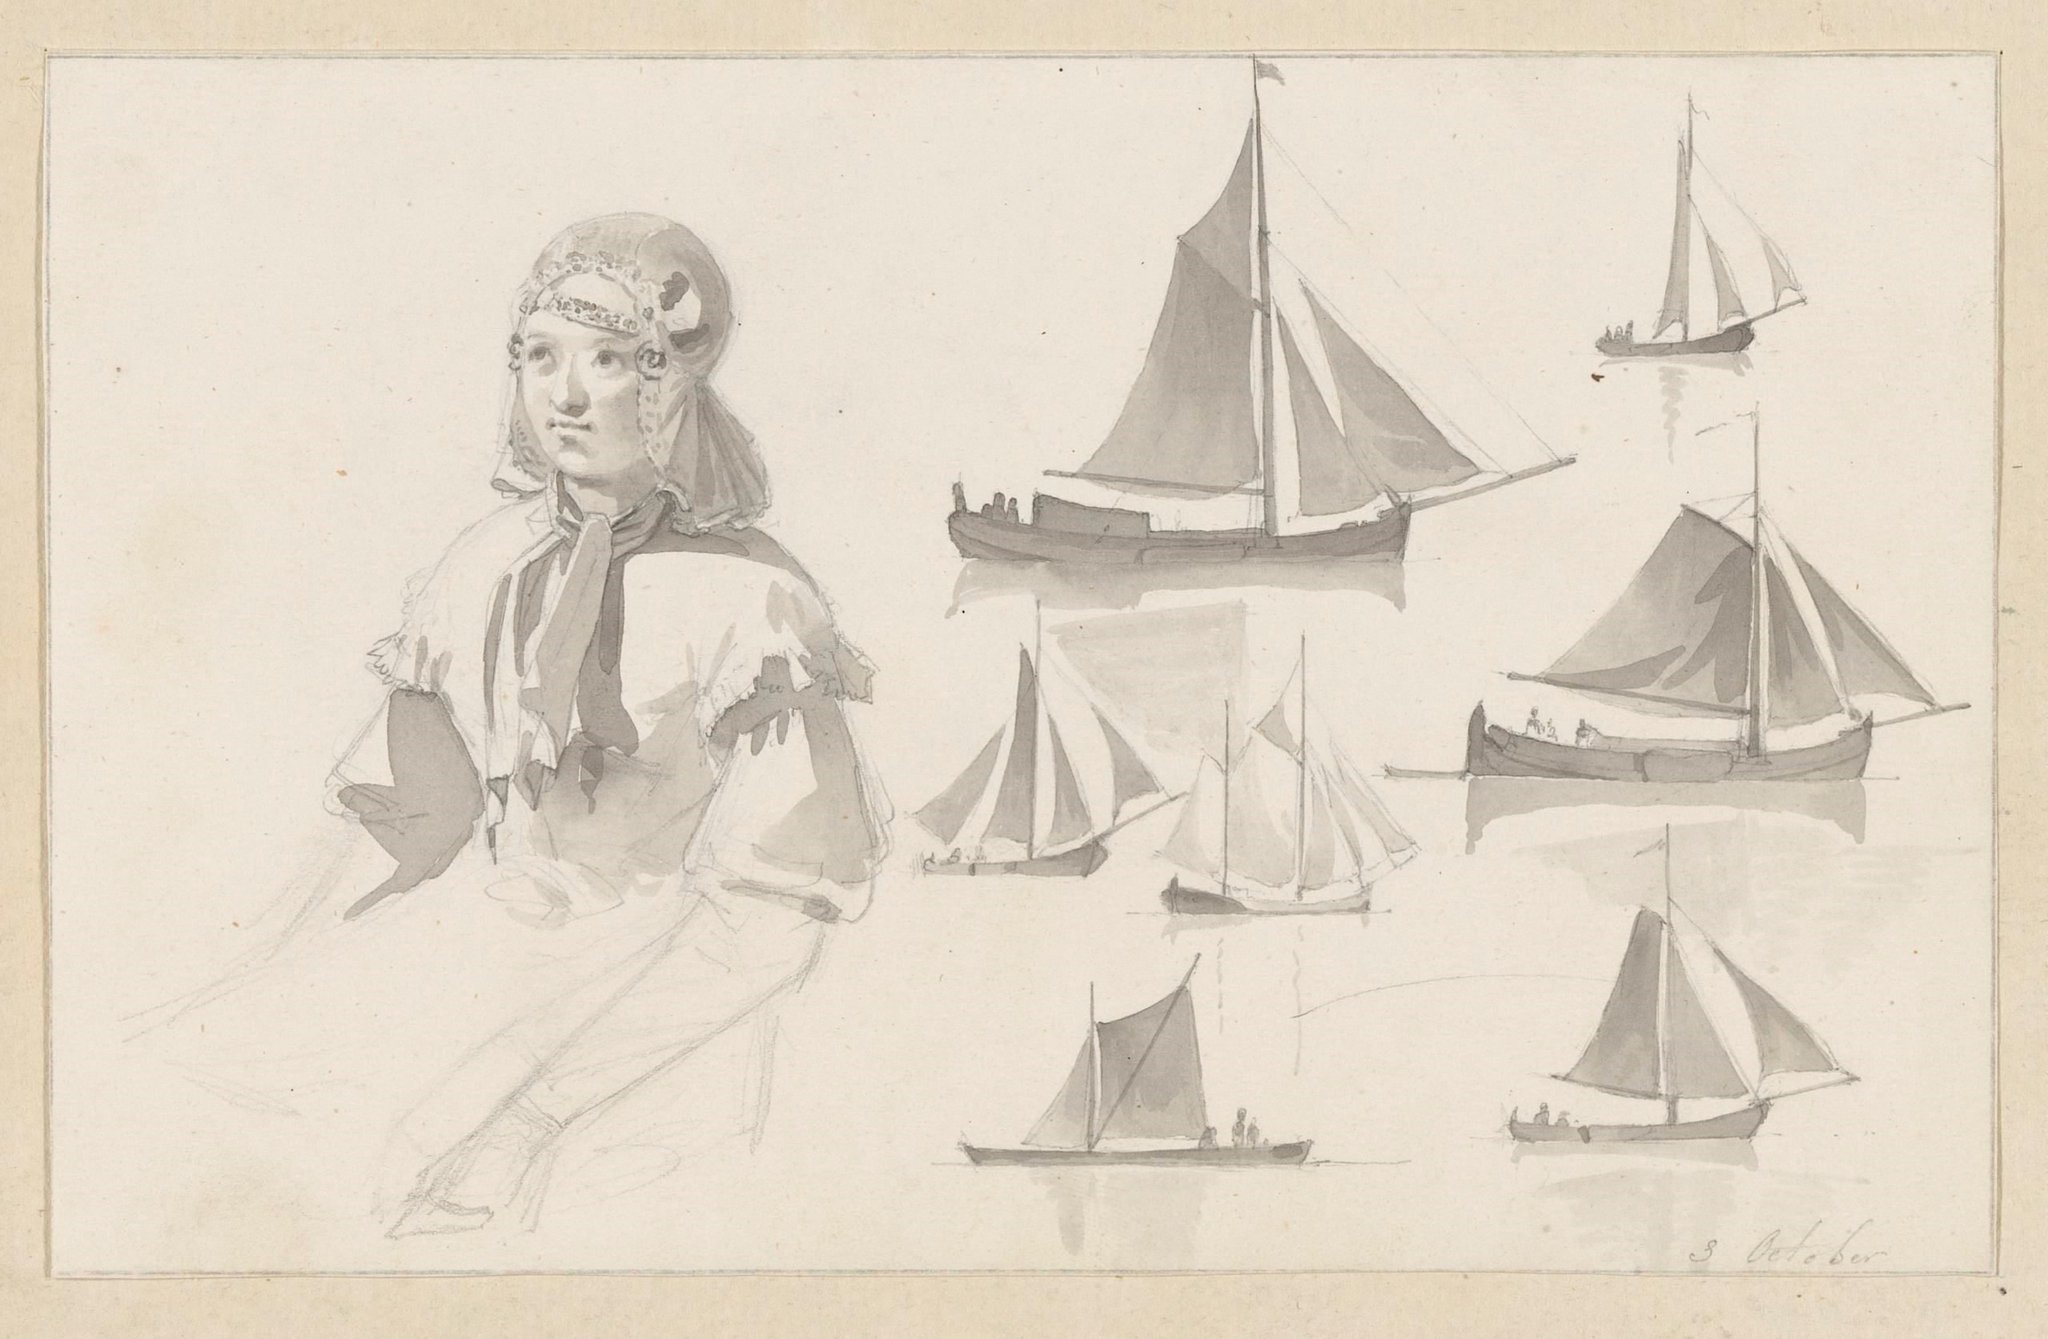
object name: drawing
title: Schetsblad met zittende vrouw en zeilschepen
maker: hendrik abraham klinkhamer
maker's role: draughtsman, painter, print maker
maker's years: 1810-1872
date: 1820-1872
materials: paper, pencil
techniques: brush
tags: sailing-ship, sailing-boat